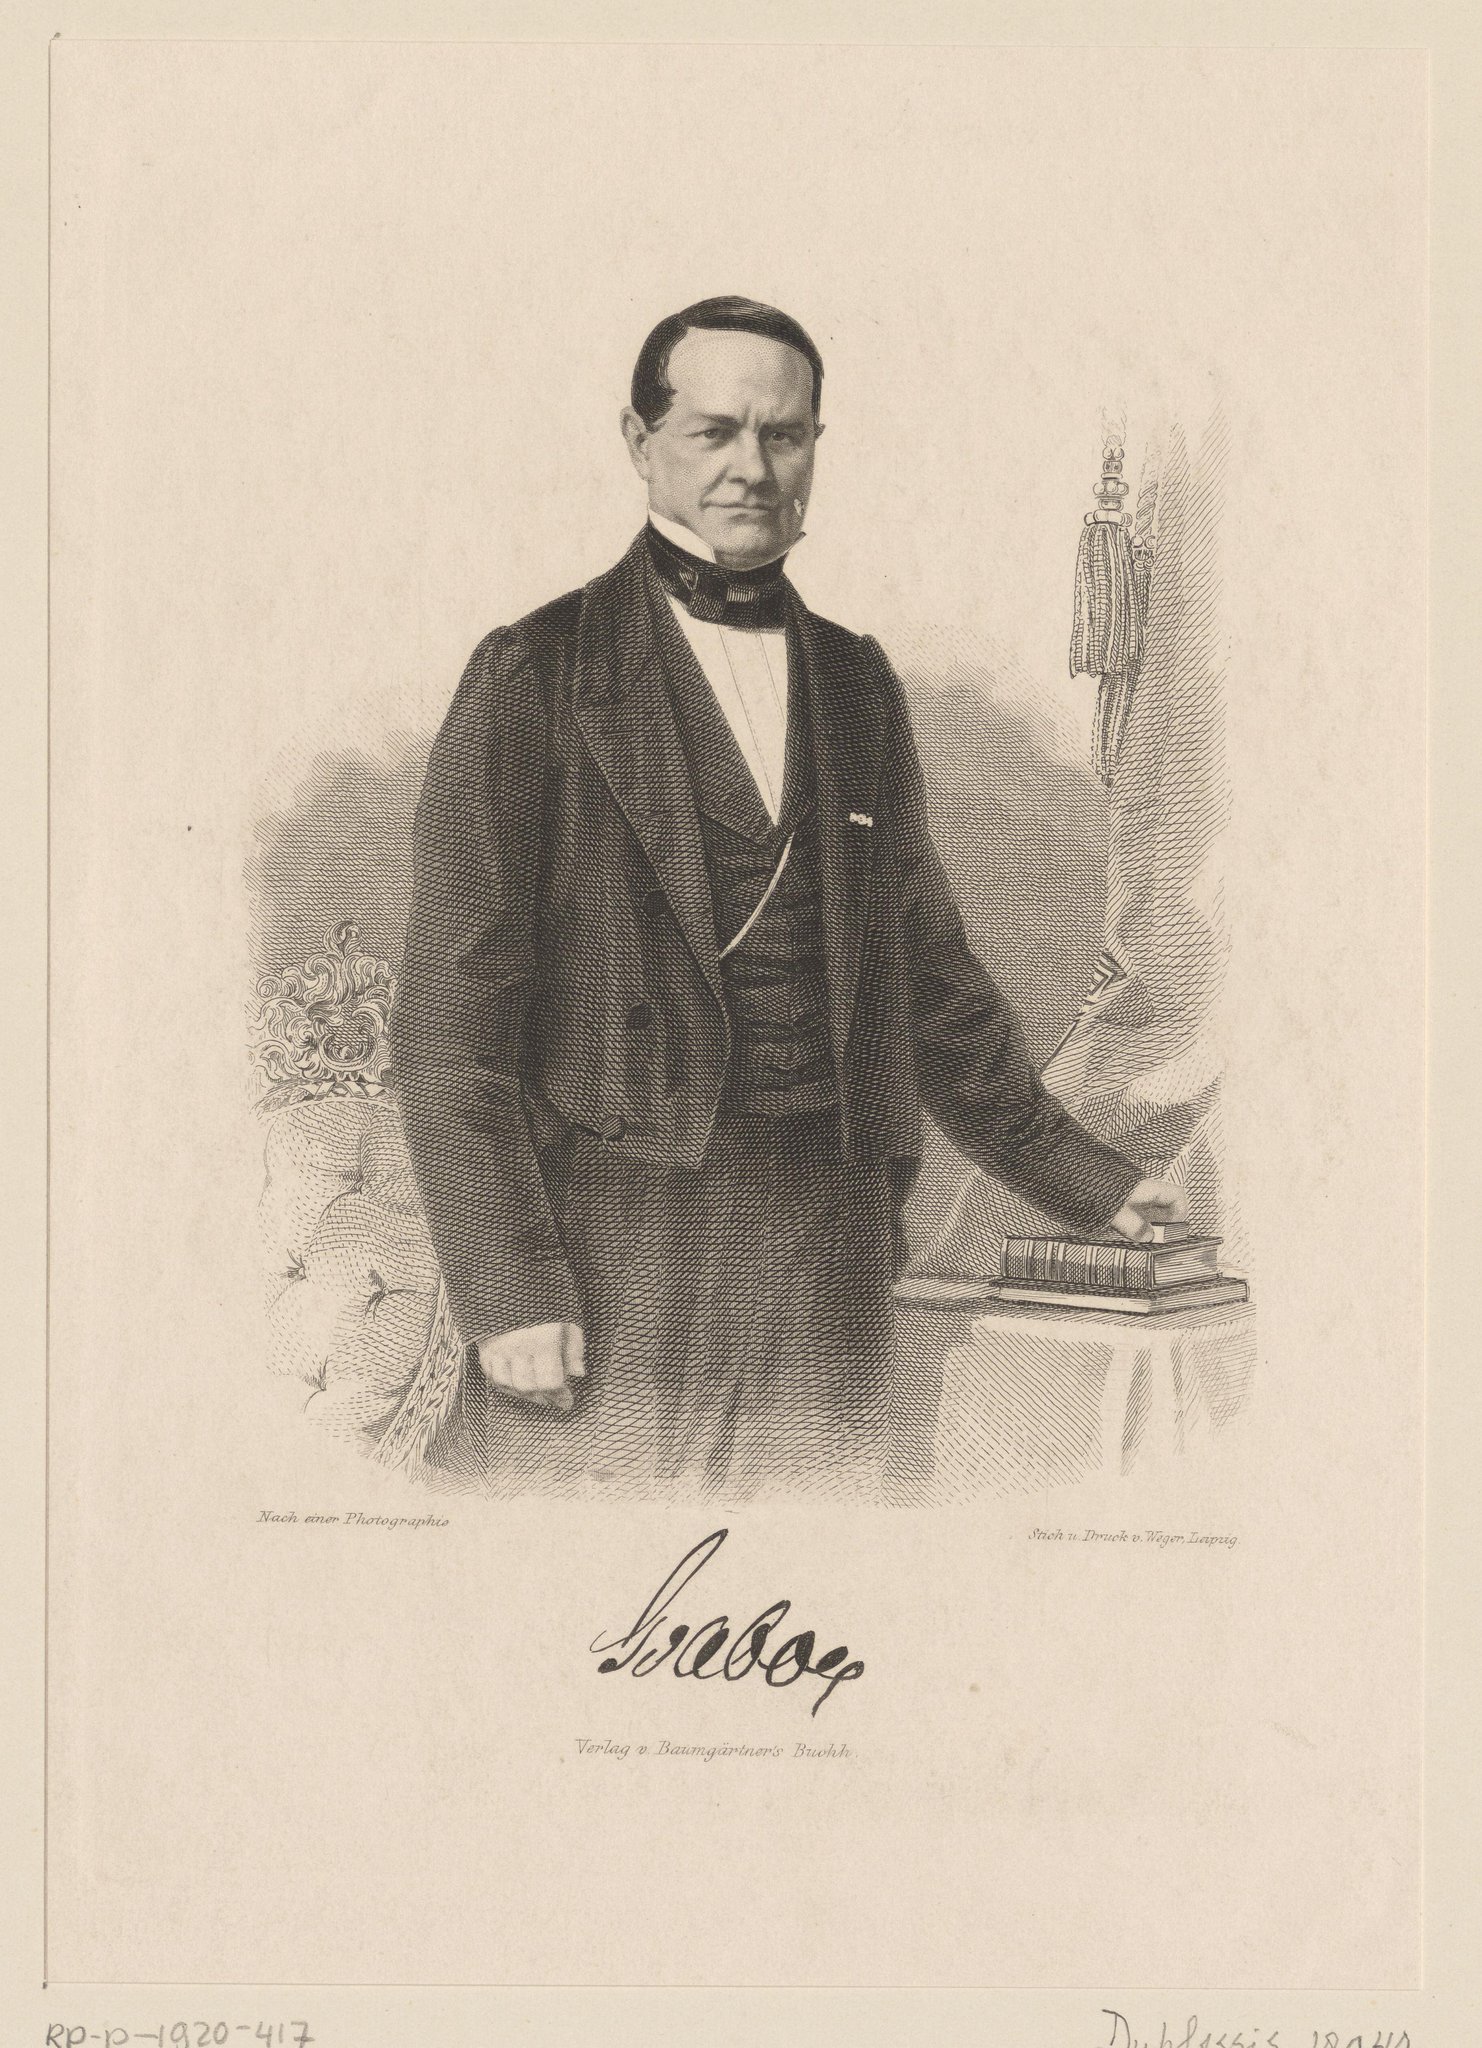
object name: print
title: Portret van Wilhelm Grabow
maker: august weger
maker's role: print maker, printer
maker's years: 1823-1892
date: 1822-1876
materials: paper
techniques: engraving, etching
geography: leipzig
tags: politician, historical persons, politician, e.g. party leader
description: Een facsimile signatuur in de ondermarge.